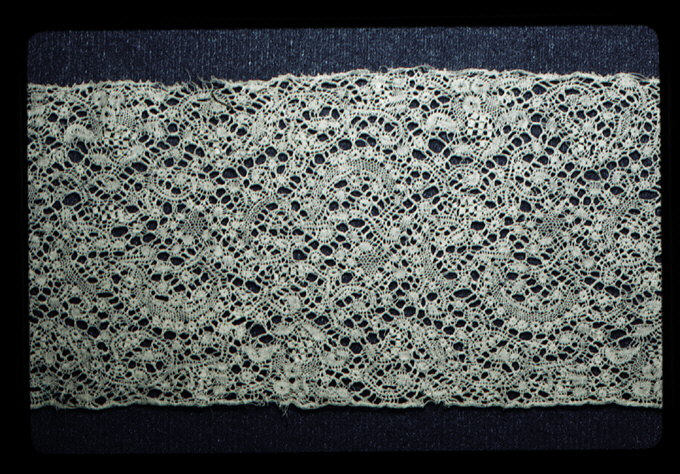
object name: strip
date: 1700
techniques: lace